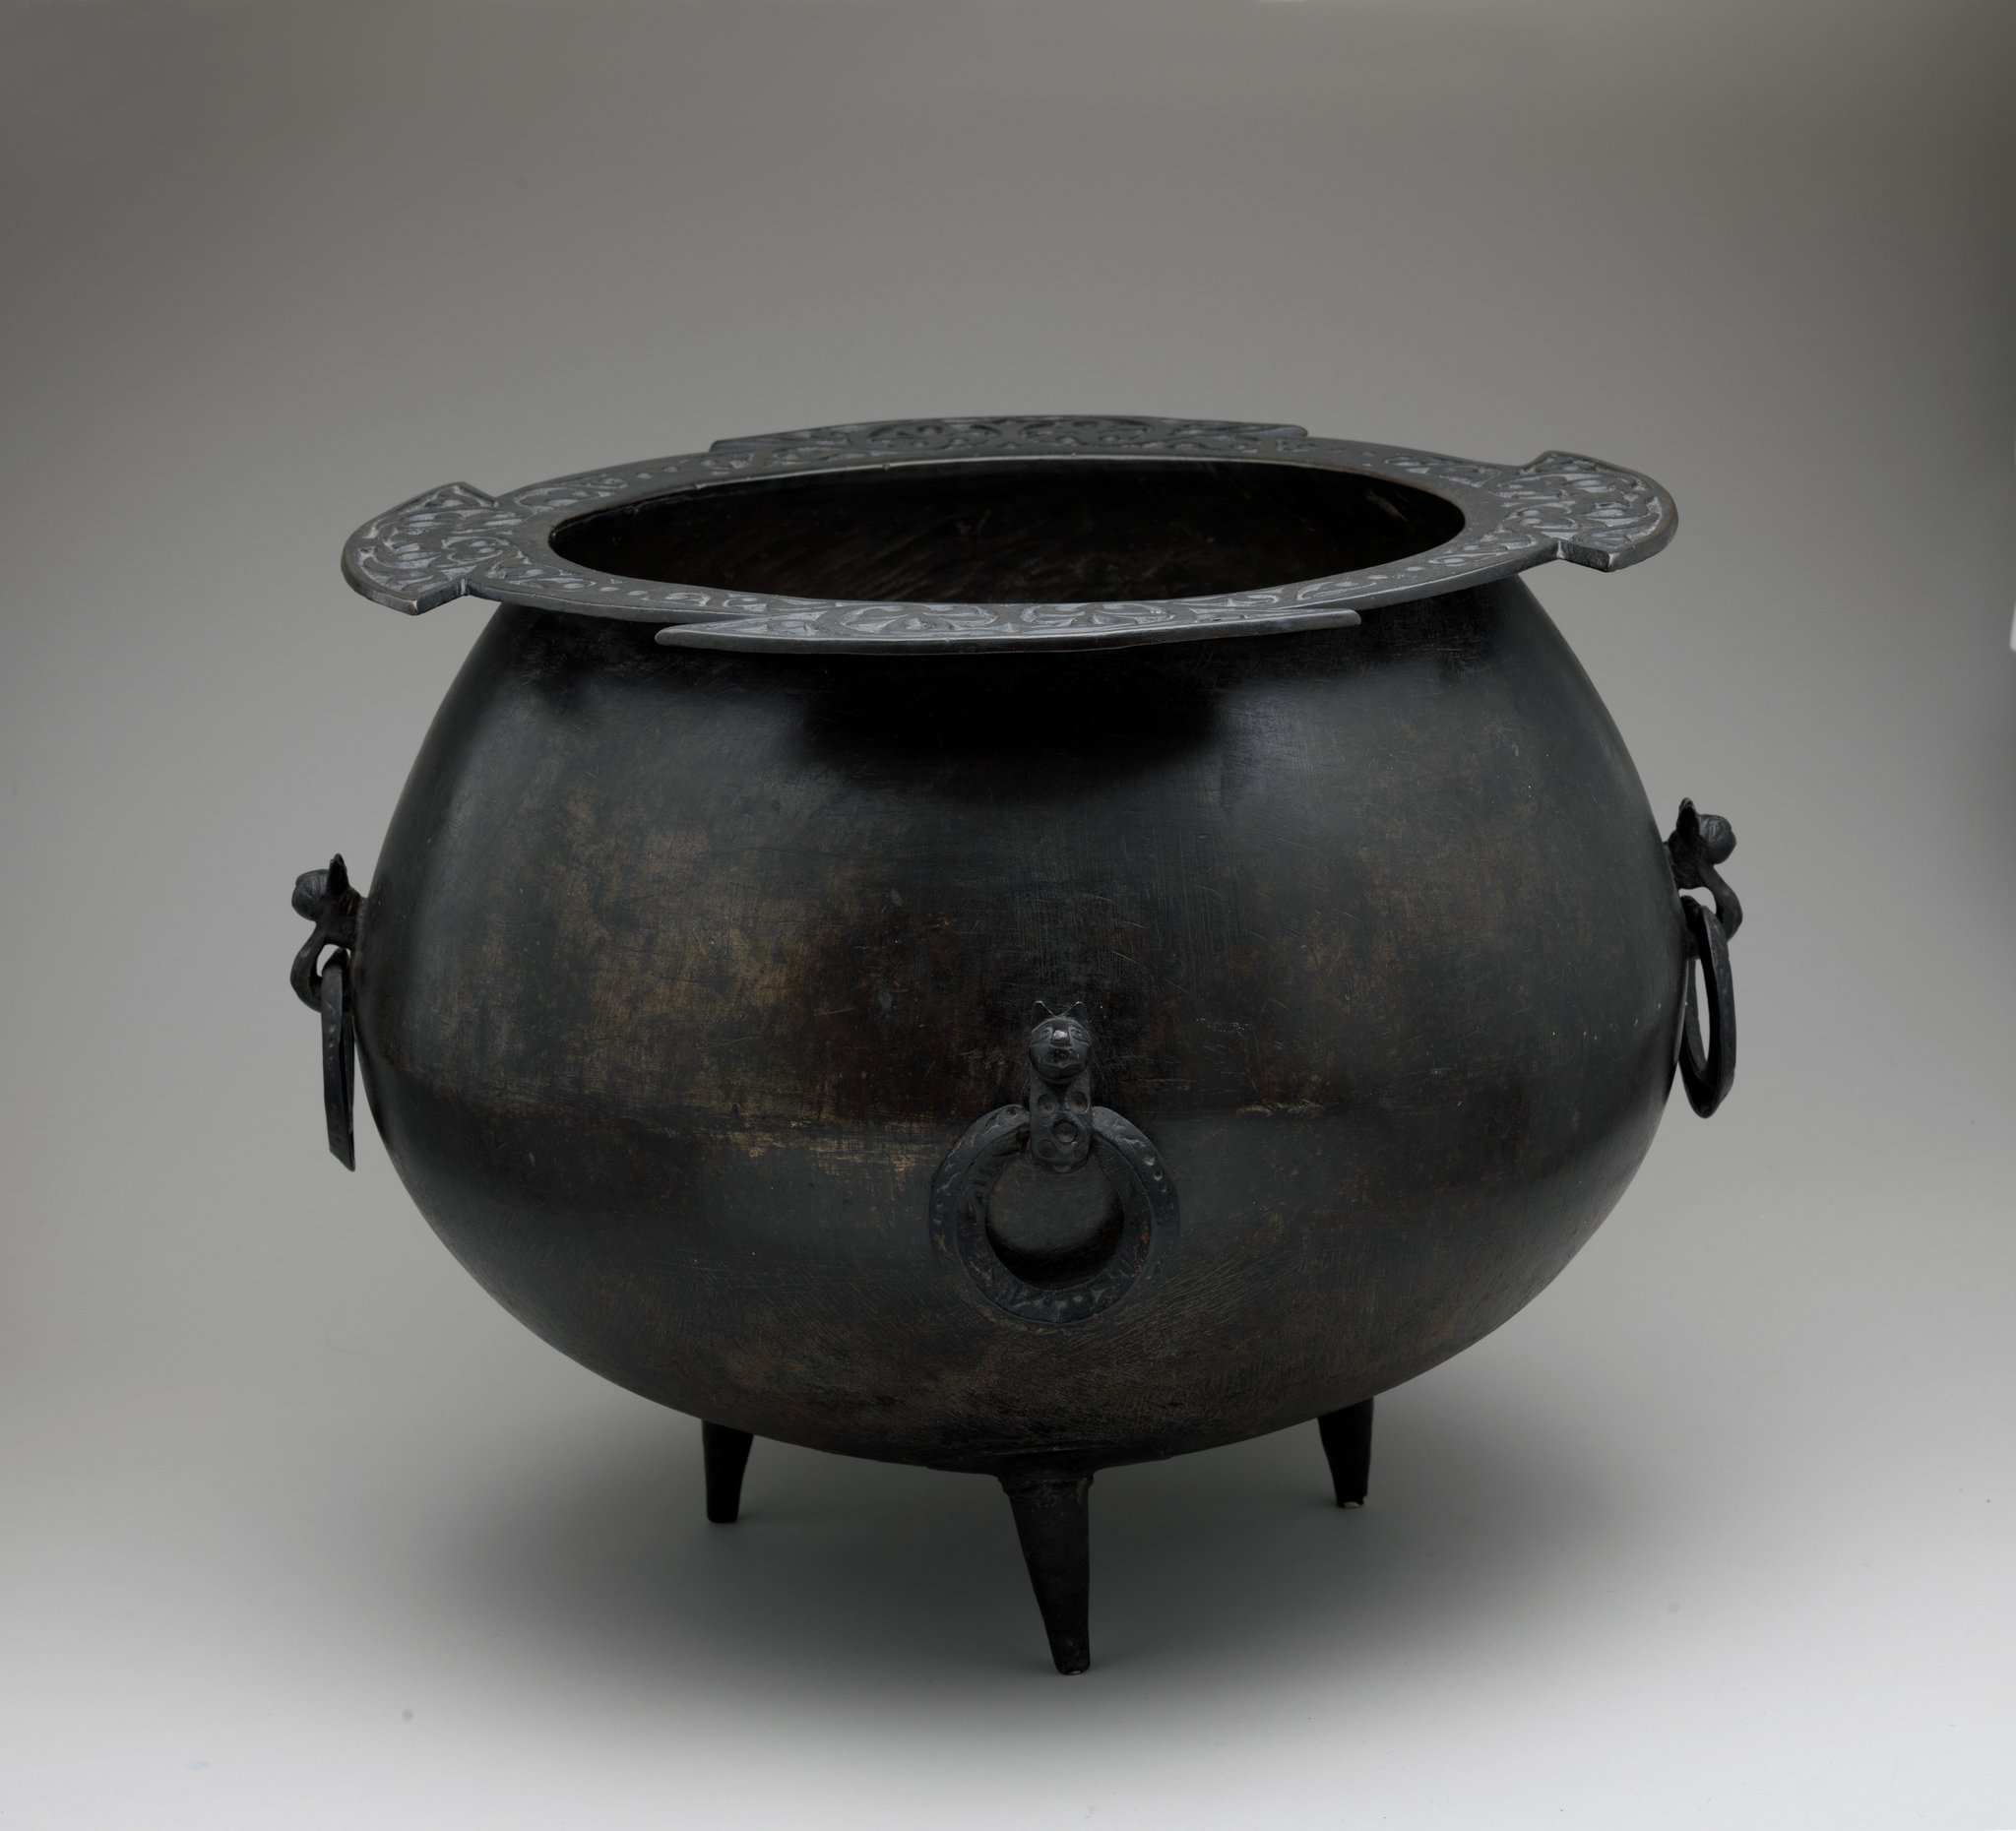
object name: cauldron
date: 1434-1466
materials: copper alloy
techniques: incising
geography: caucasus